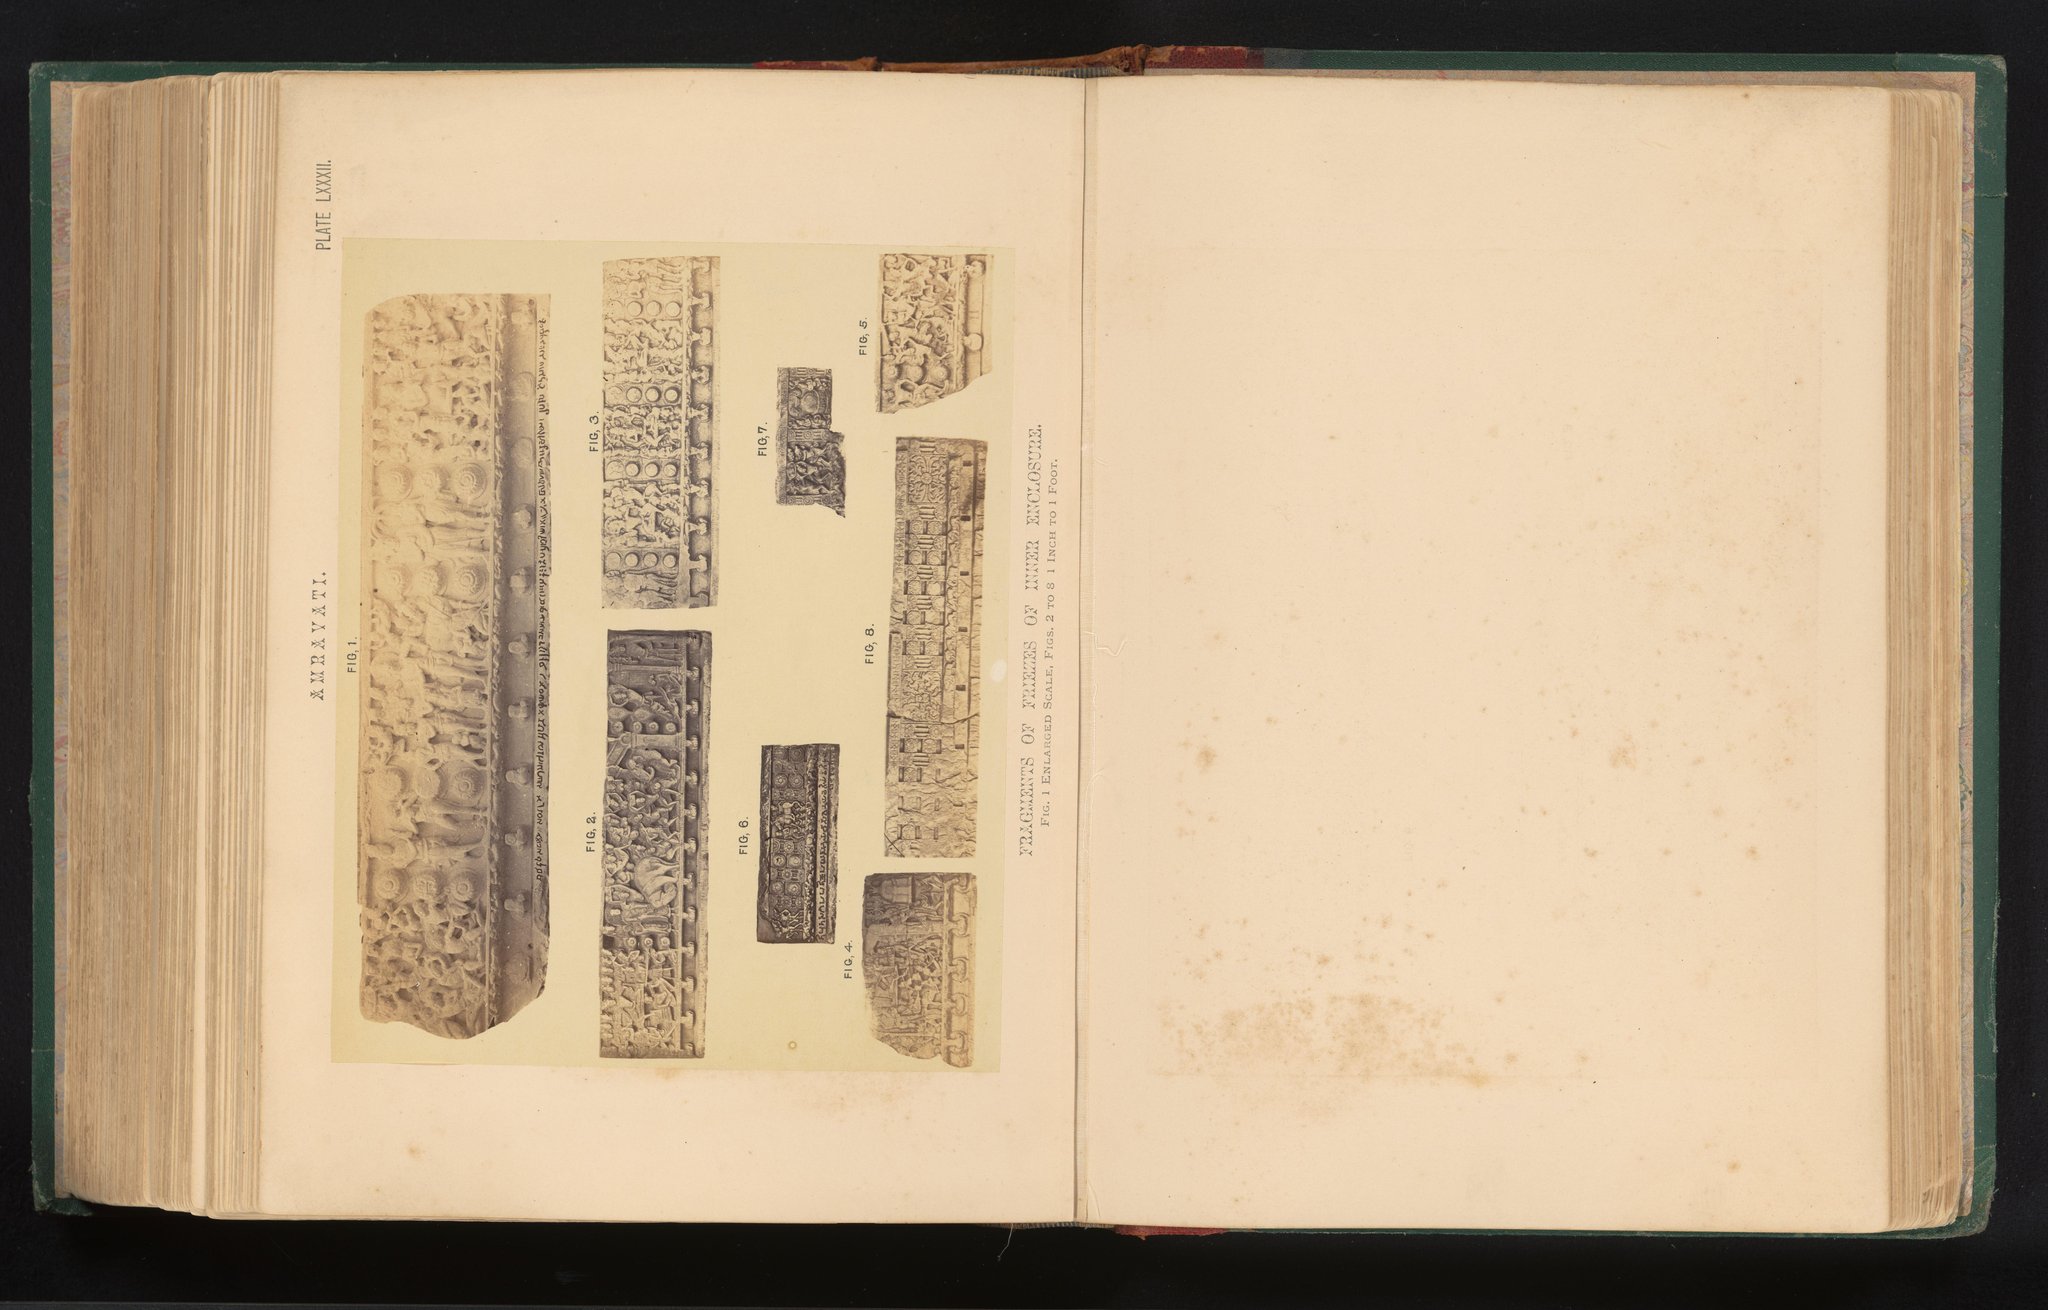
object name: photograph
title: Eight fragments of friezes with relief, Amaravati, Andhra Pradesh, India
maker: william h. griggs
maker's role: printer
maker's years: 1832-1911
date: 1863-1868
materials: photographic support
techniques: albumen print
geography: amaravati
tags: hinduism, buddhism, jainism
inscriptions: inscription: ‘FRAGMENTS OF FRIEZES OF INNER ENCLOSURE./ FIG. 1 ENLARGED SCALE, FIGS. 2 TO 8 1 INCH TO 1 FOOT.’, inscription: ‘AMRAVATI. PLATE LXXXII.’